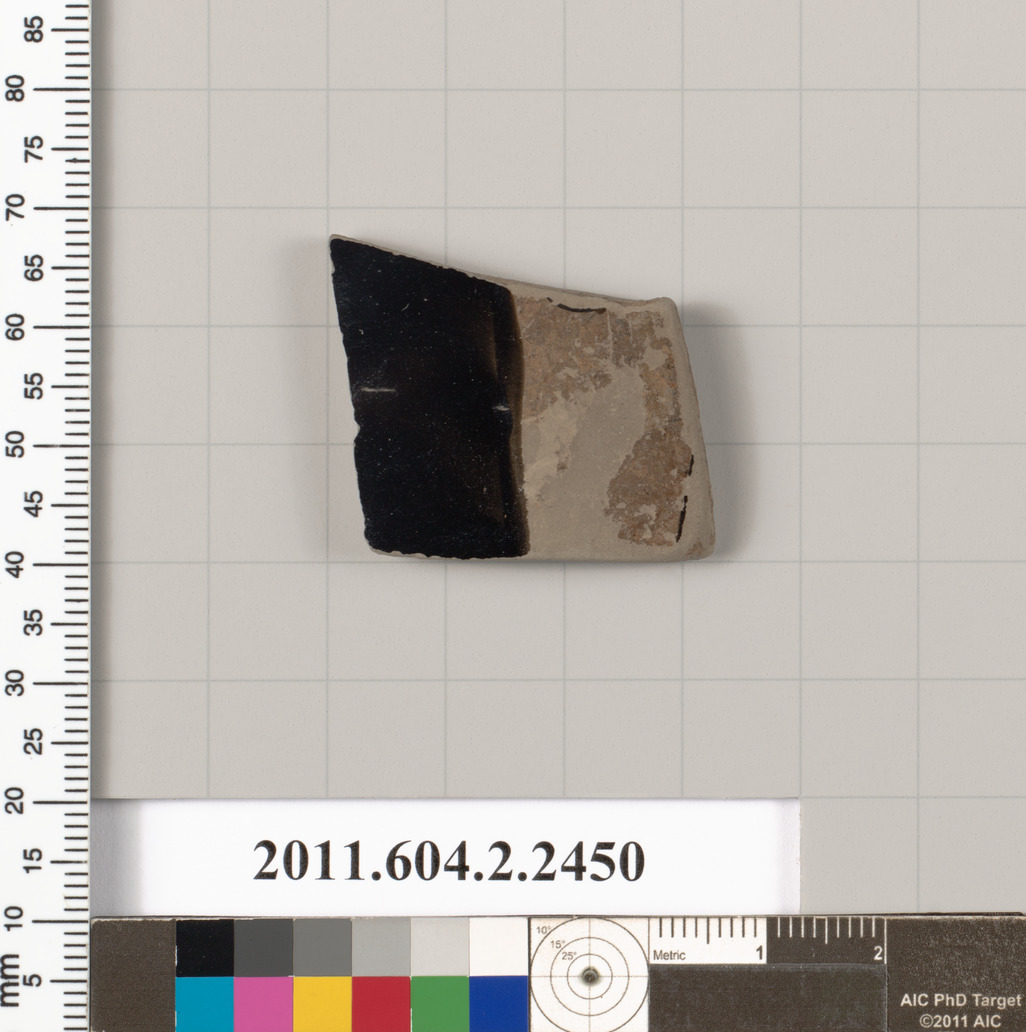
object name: undetermined closed shape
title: Terracotta fragment of a closed shape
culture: greek, attic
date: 475-451 BCE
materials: terracotta